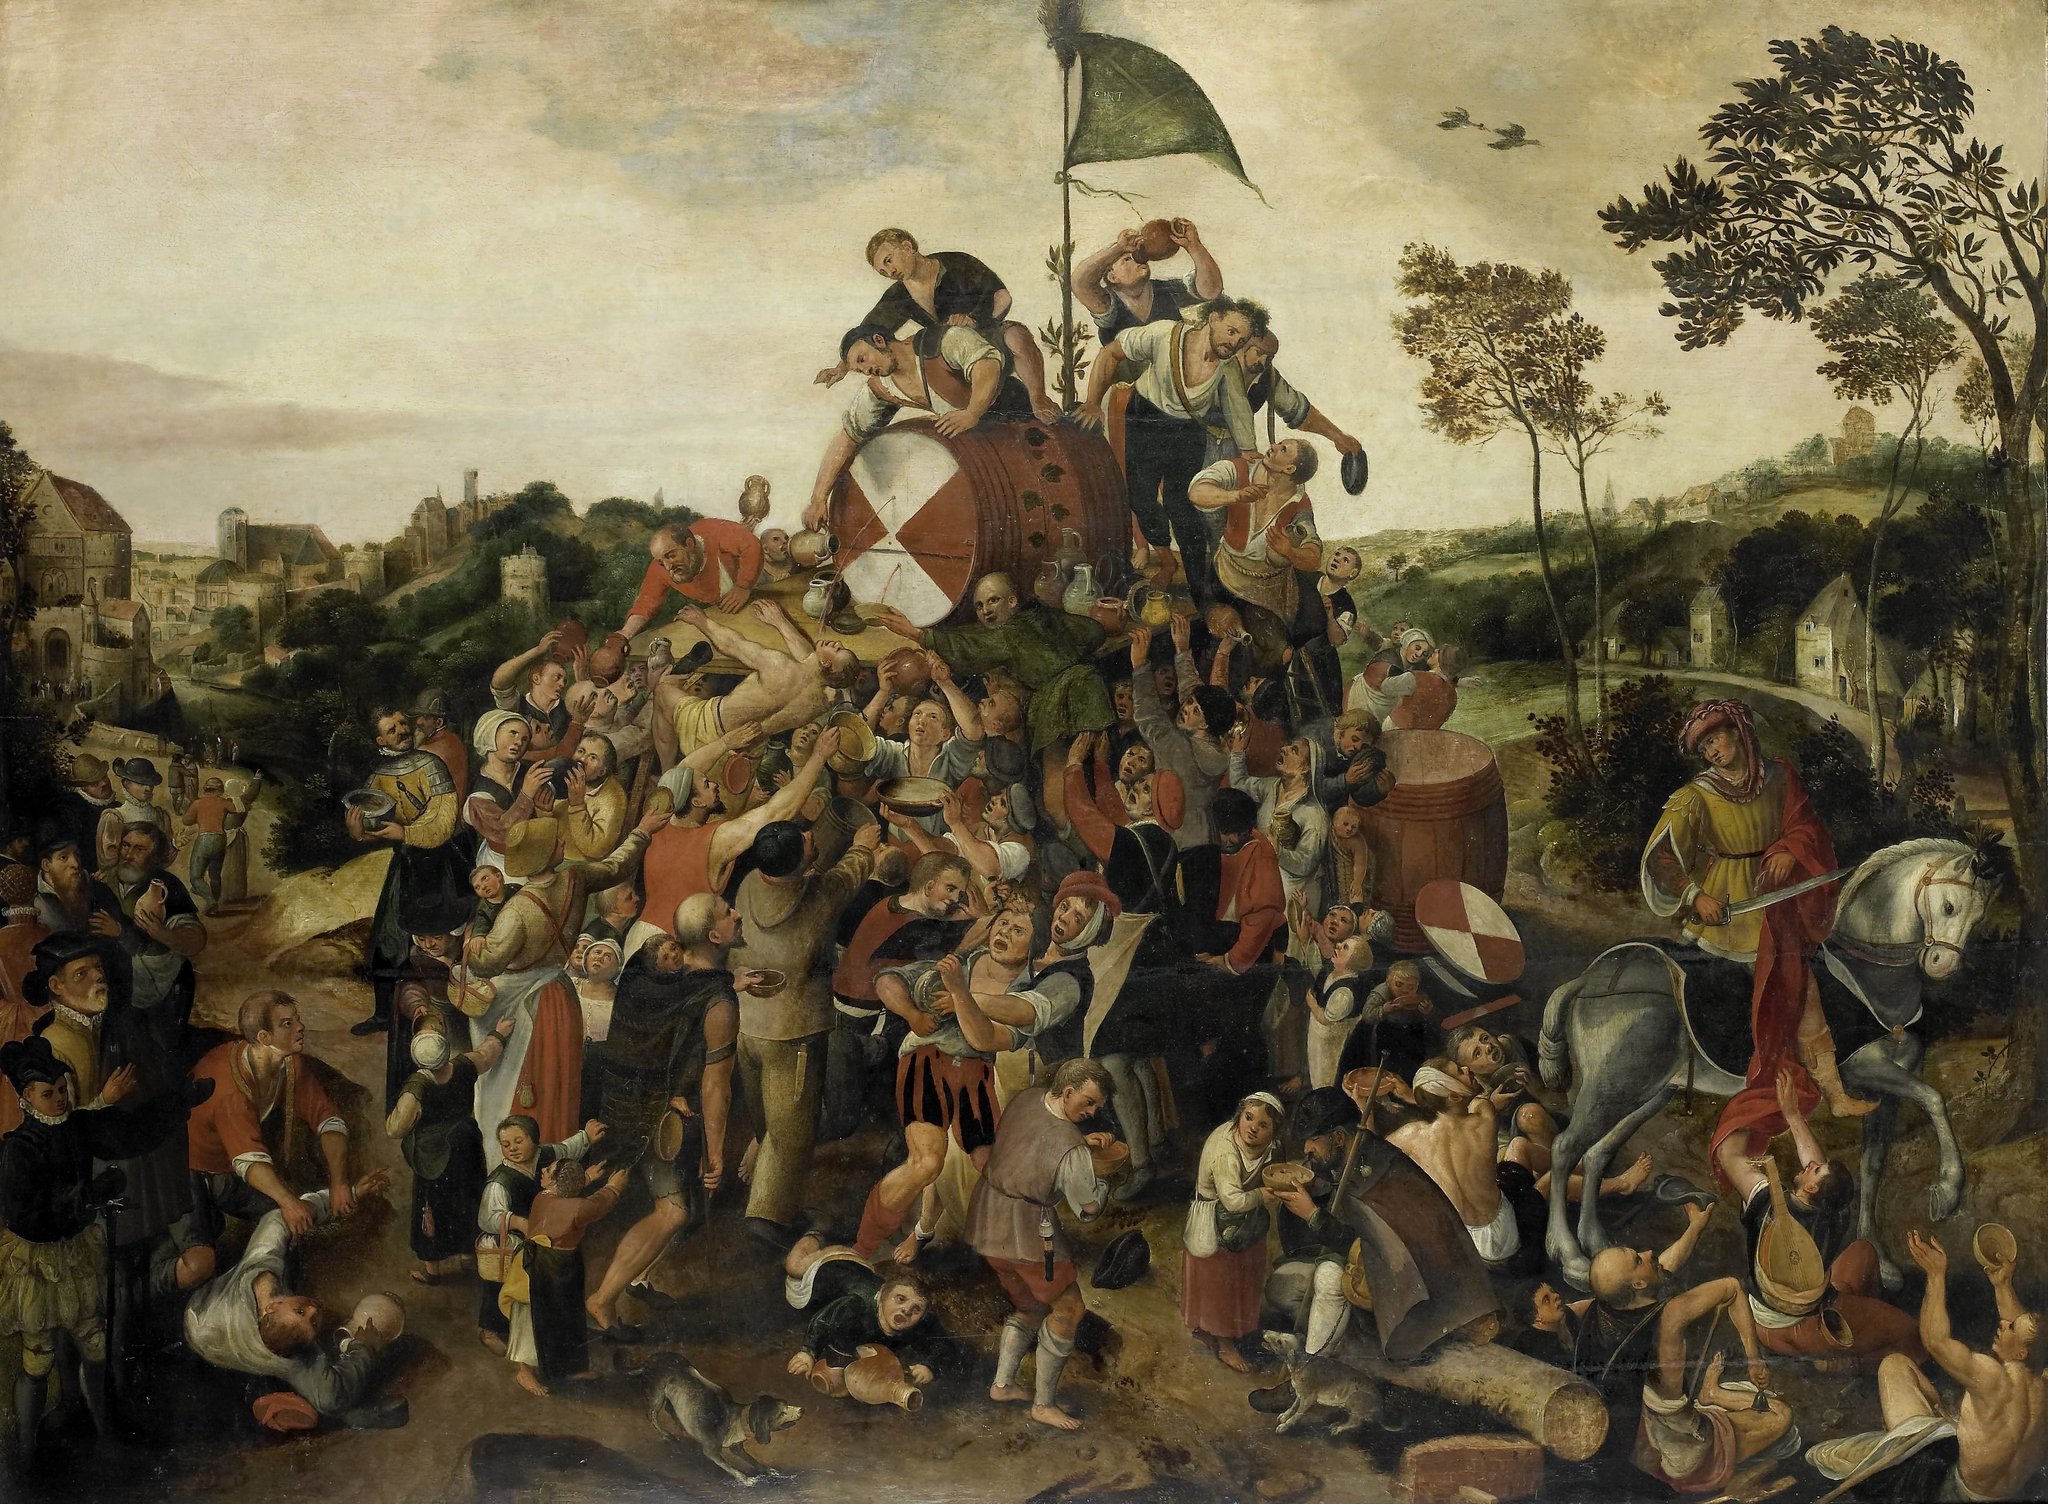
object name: painting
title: The St Martin's Day Kermis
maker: peeter baltens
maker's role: draughtsman, painter, print maker, publisher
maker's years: 1527-1584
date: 1540-1598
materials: oil, panel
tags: st. martin's day (november 11), st. martin divides his cloak (i.e. the charity of st. martin): he is usually shown on horseback, cutting his cloak with his sword, or putting part of the cloak round the shoulders of a beggar who kneels beside him, carnival, shrovetide (non-liturgical celebration), pleasure fair and circus, calendar festivals, non-liturgical celebrations of days belonging to the ecclesiastical calendar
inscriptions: signature: ‘Peeter Balten’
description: De Sint Maartenskermis. Een menigte vecht en verdringt zich rond een vat wijn. Rechts de heilige Martinus die zijn mantel deelt met bedelaars. Op de voorgrond een bedevaartganger.